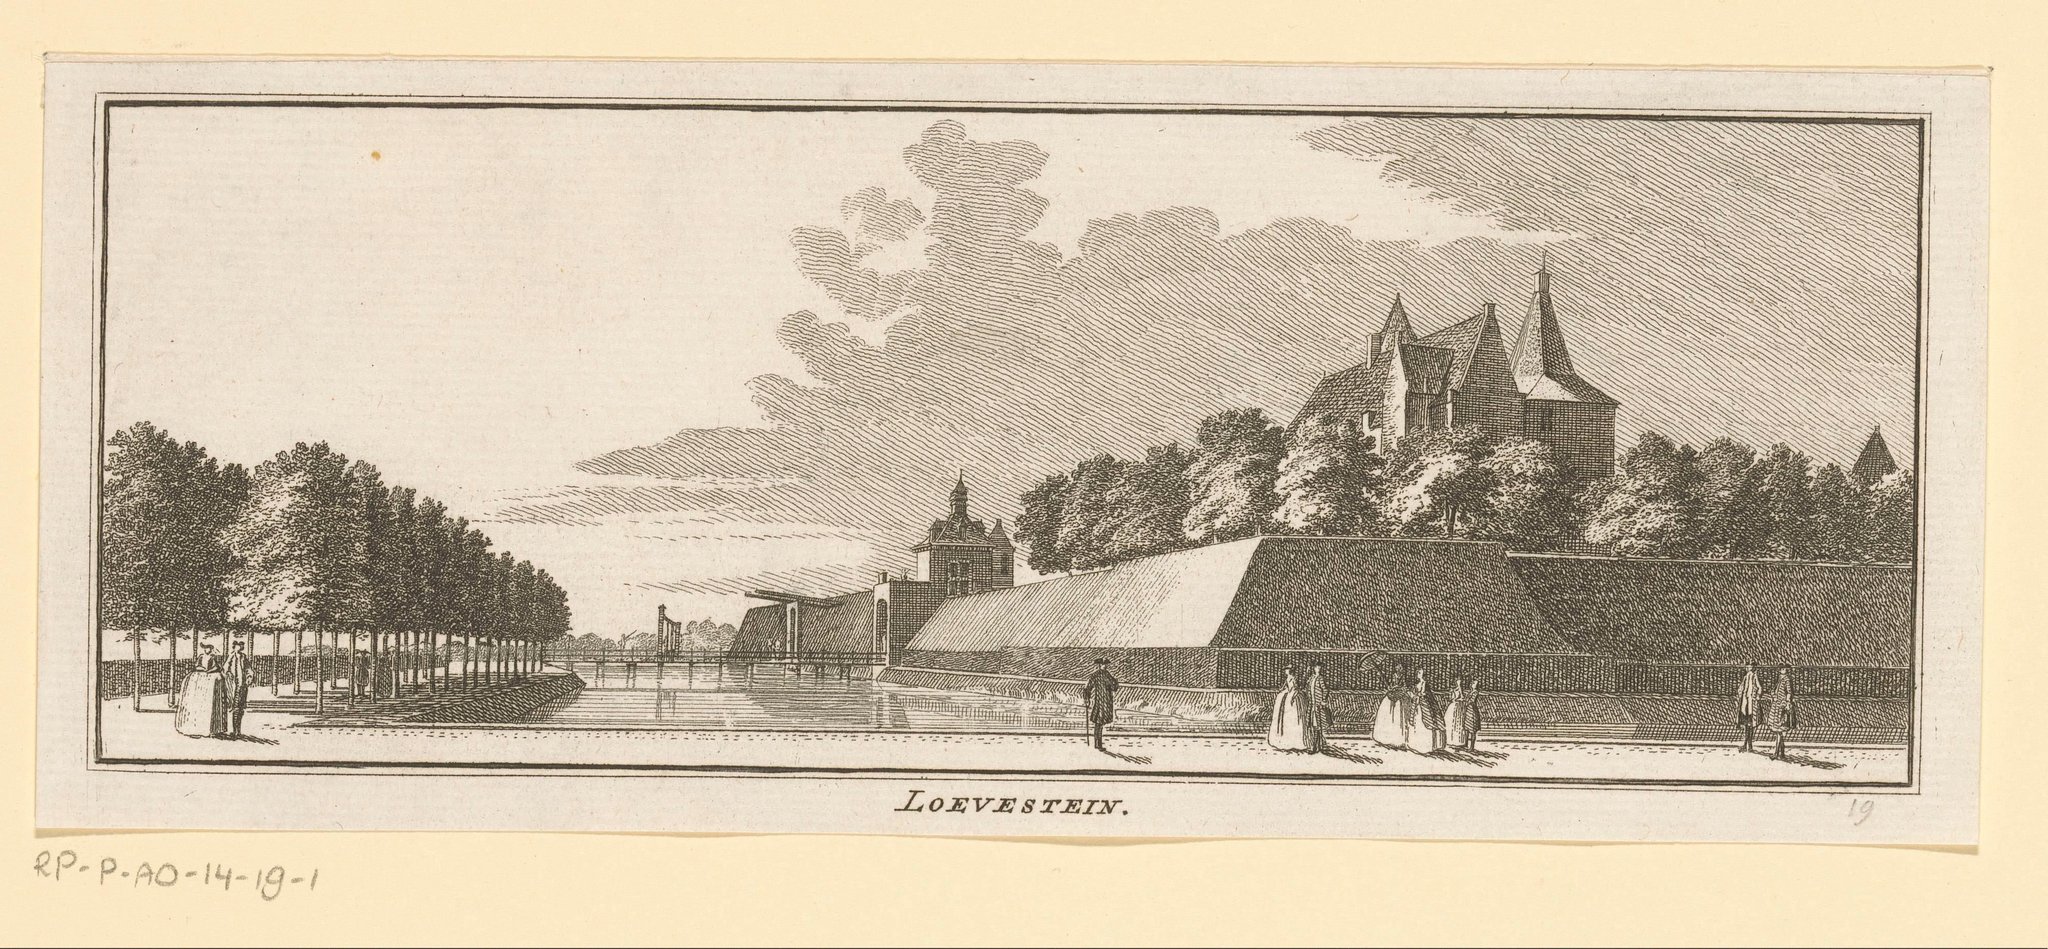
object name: book illustration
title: Loevestein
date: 1749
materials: paper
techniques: etching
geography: amsterdam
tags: castle, bridge, loevestein castle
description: Gezicht op Slot Loevestein met slotgracht, vestingwal, toegangsbrug en -poort. Op de voorgrond wandelende figuren.